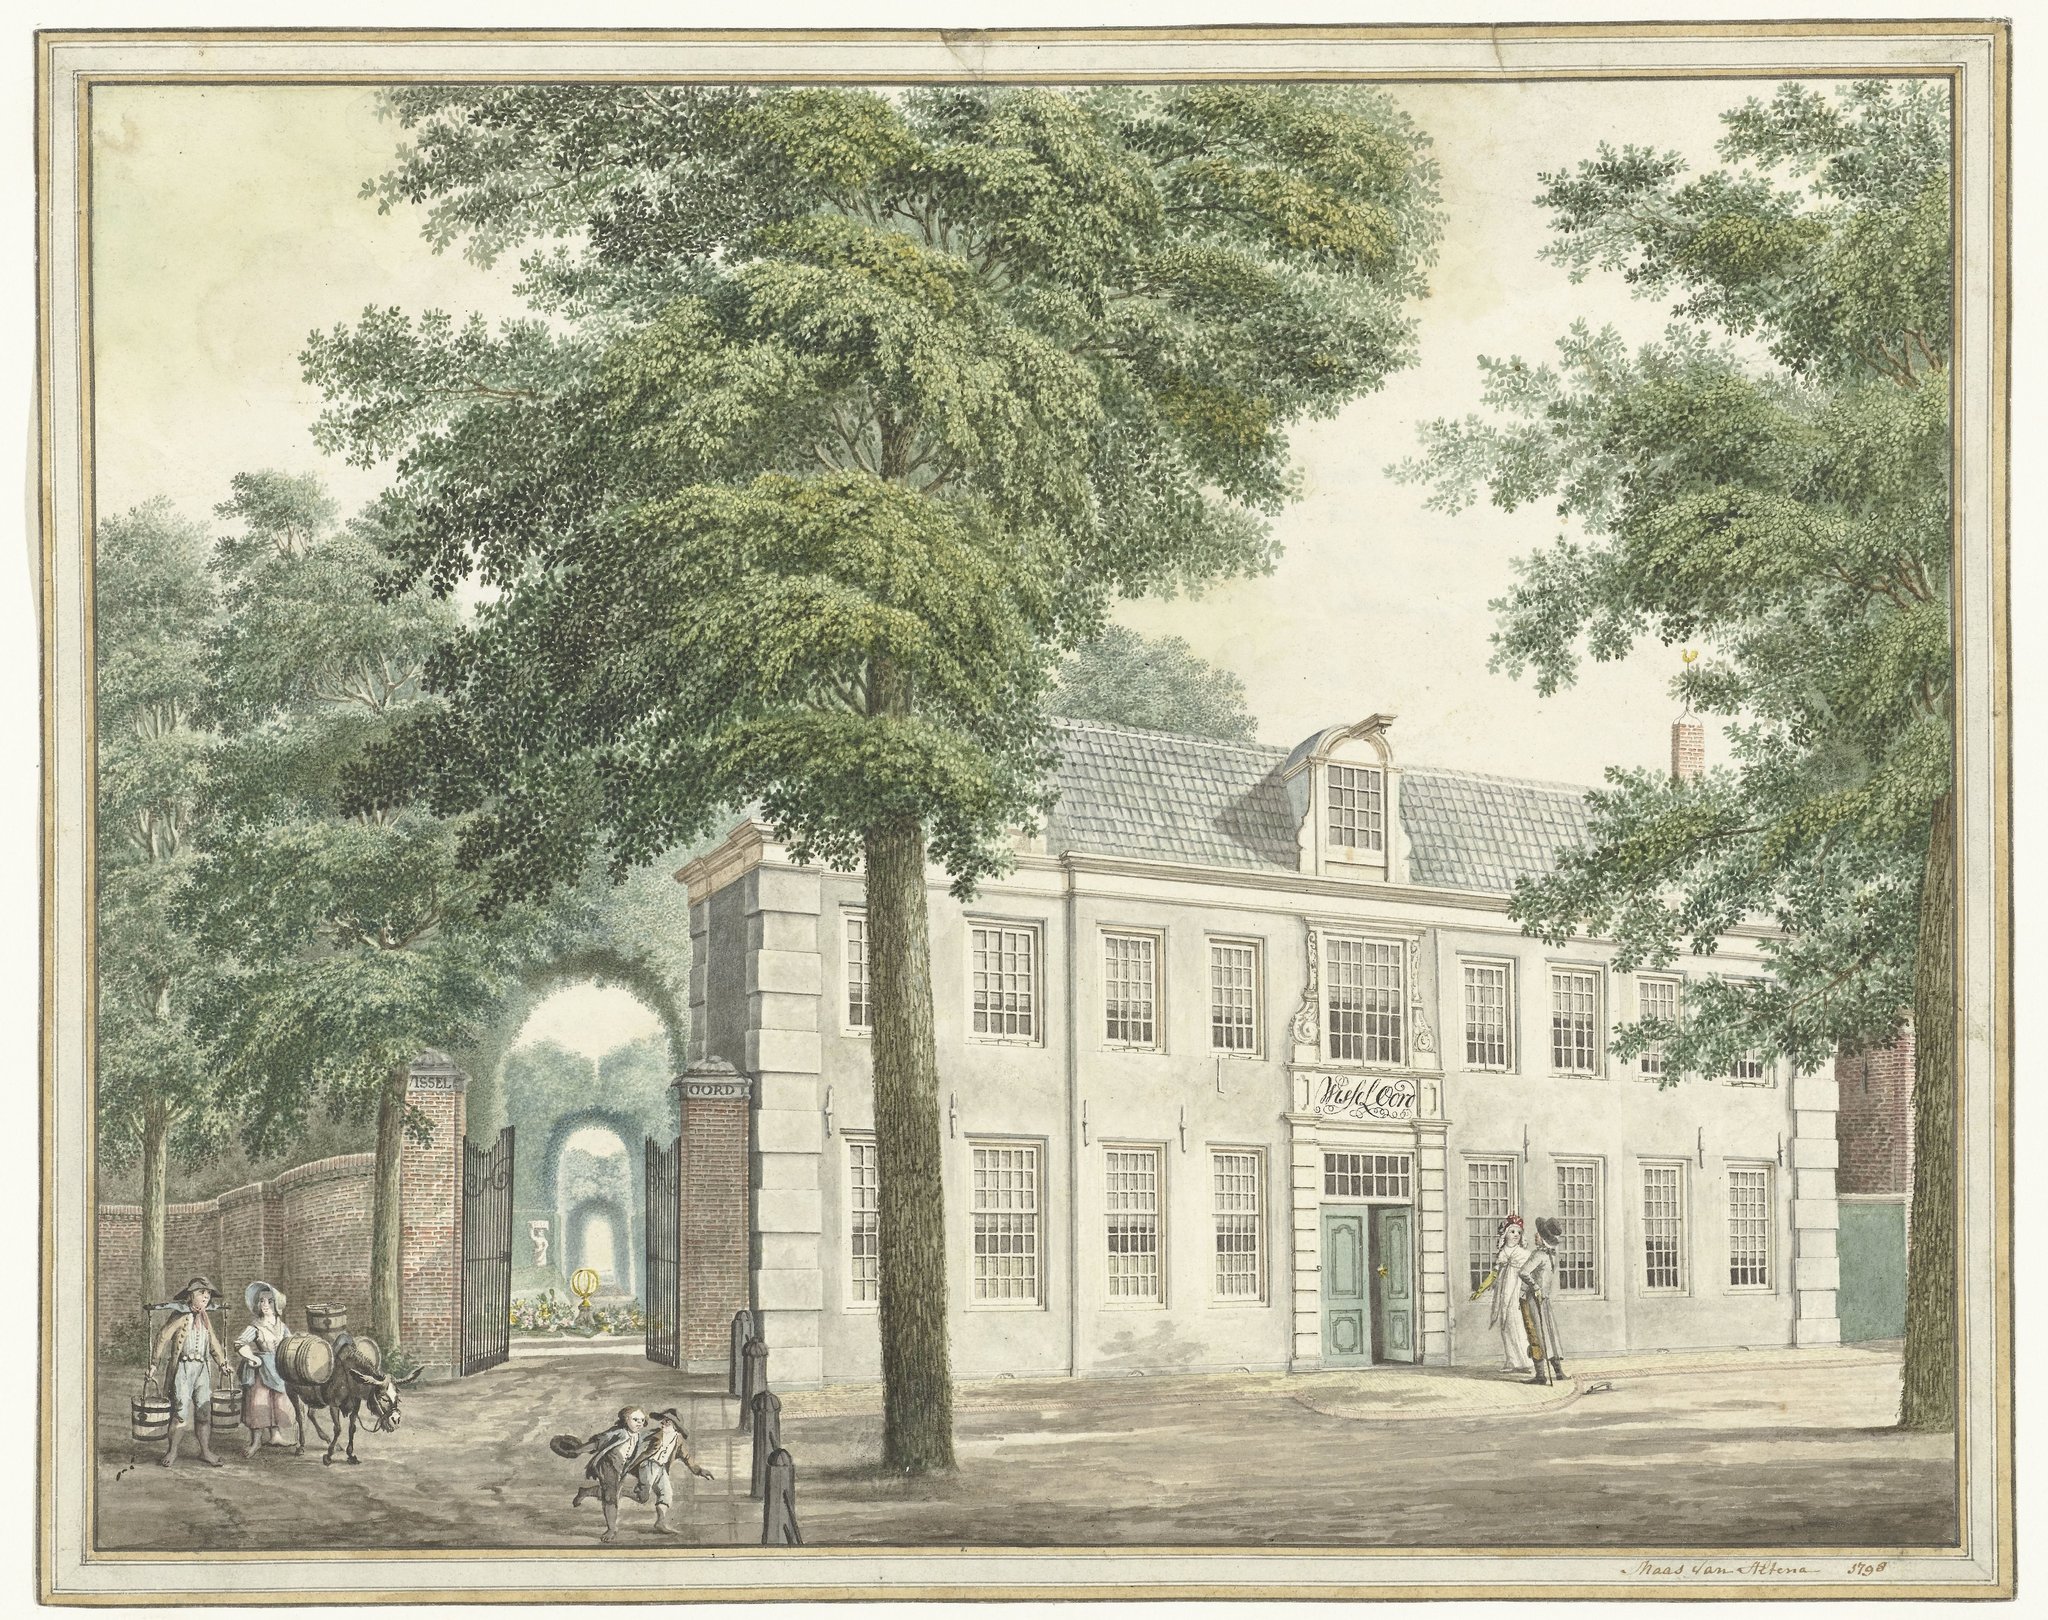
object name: drawing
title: Wisseloord te Muiderberg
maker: maas van altena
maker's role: draughtsman, print maker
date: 1798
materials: ink, paper, watercolor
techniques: brush, pen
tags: city-view, and landscape with man-made constructions